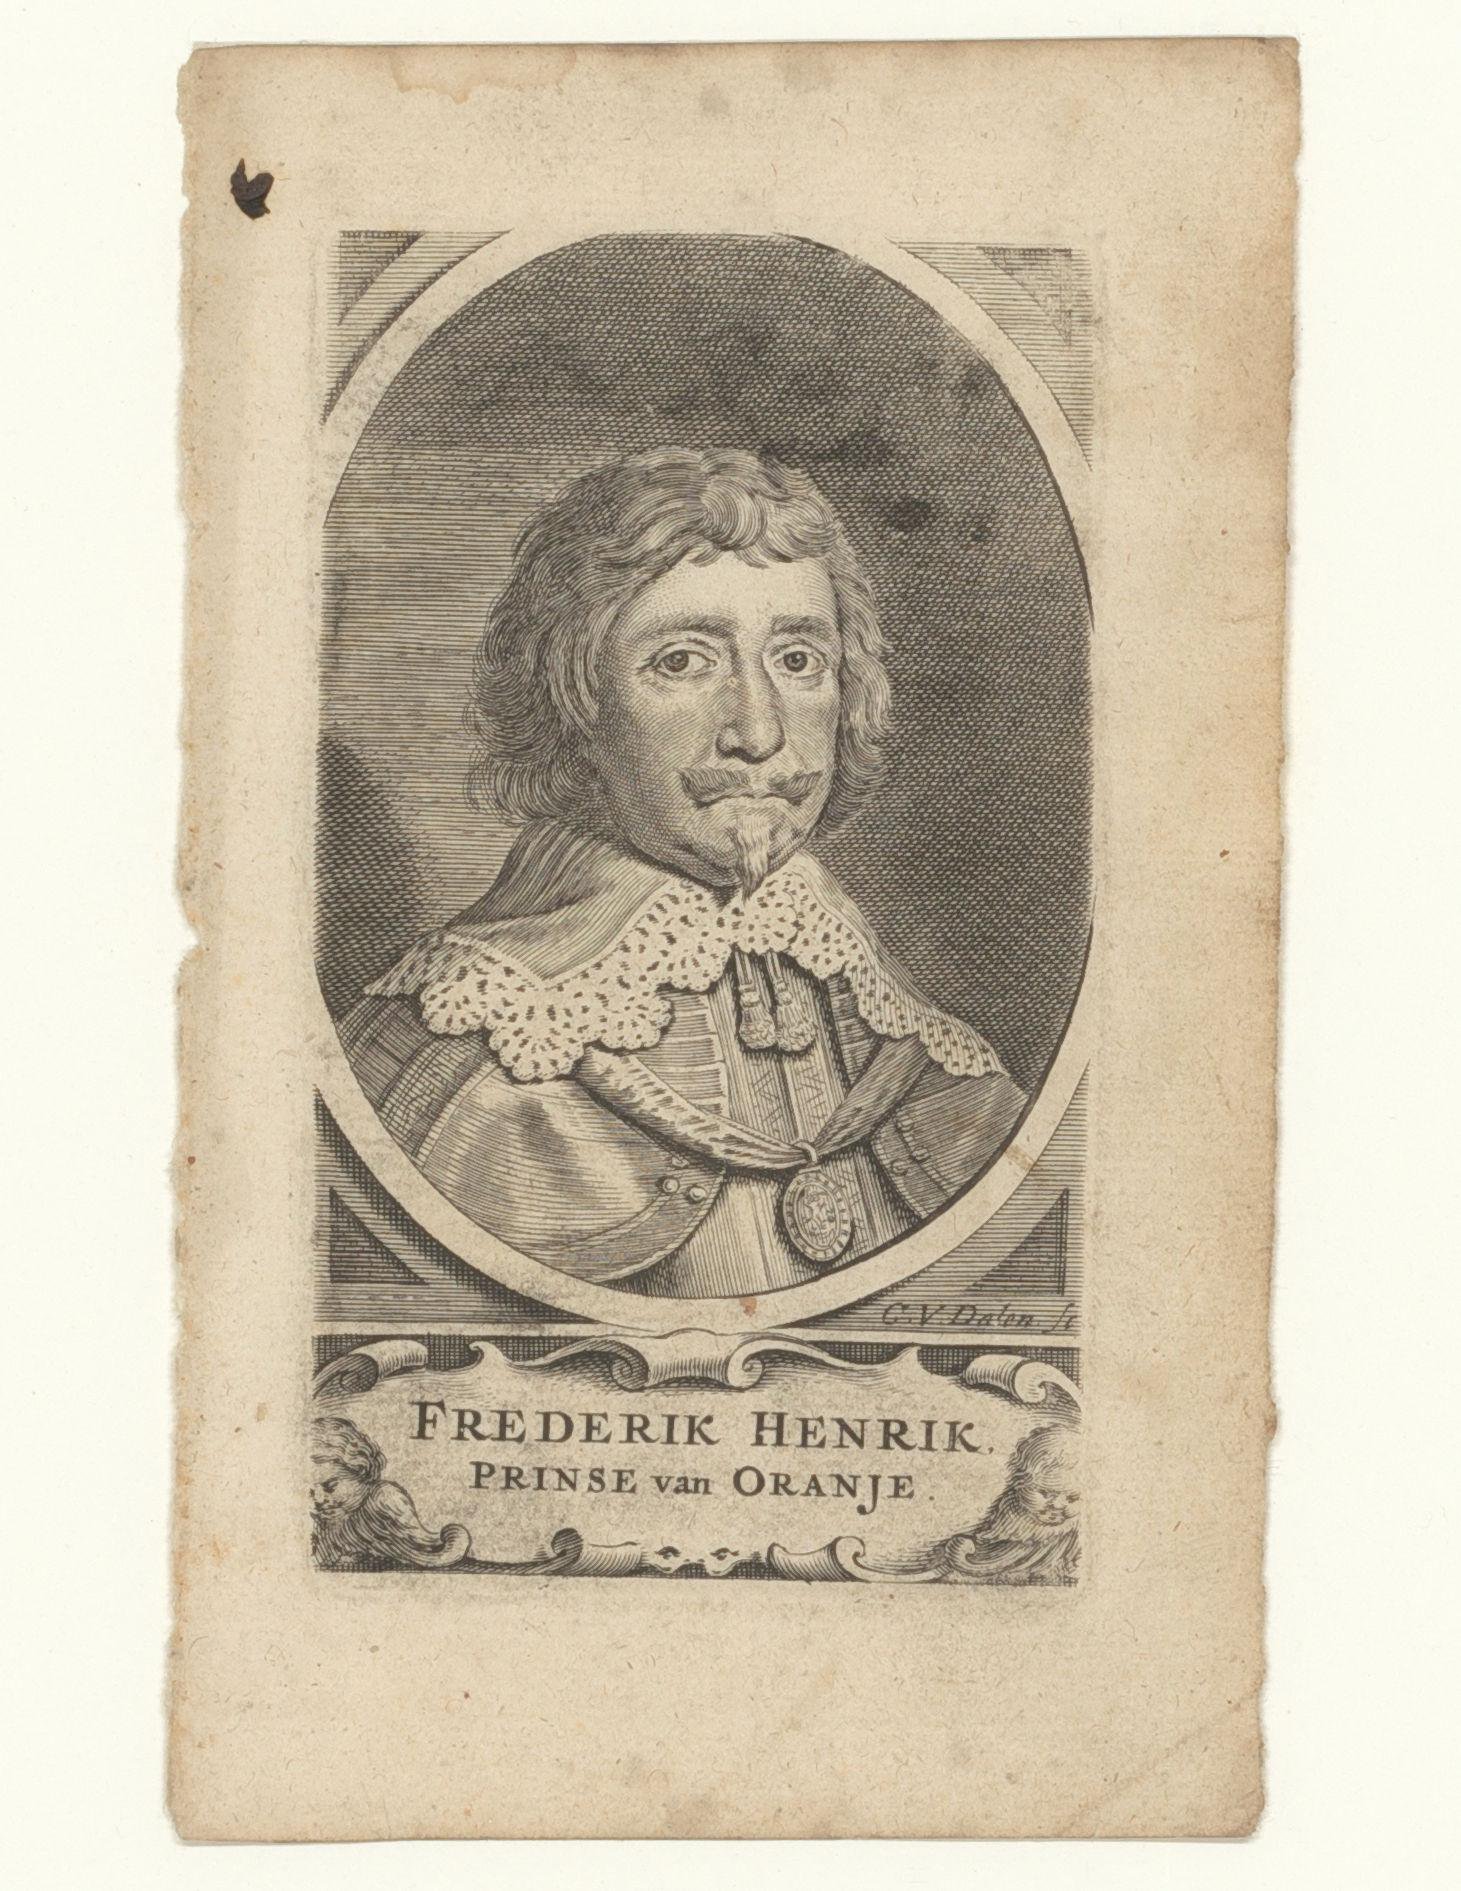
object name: print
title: Frederik Hendrik Prinse van Oranje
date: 1664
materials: paper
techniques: engraving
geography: amsterdam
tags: delft, the hague, frederick henry (prince of orange), knighthood order (garter) - insignia of a knighthood order, e.g.: badge, chain, historical persons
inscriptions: stamp, collector's mark: Lugt 1641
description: De hier vermelde titel verwijst naar de hoogst verkregen titel van de geportretteerde, niet per se naar de titel die de geportretteerde op deze voorstelling draagt. Prent uit: Montanus, Arnoldus. 't Leven en bedryf der prinsen van Oranje. Amsterdam: Arent Gerritsz. van den Heuvel en Samuel Imbrechts, 1664.